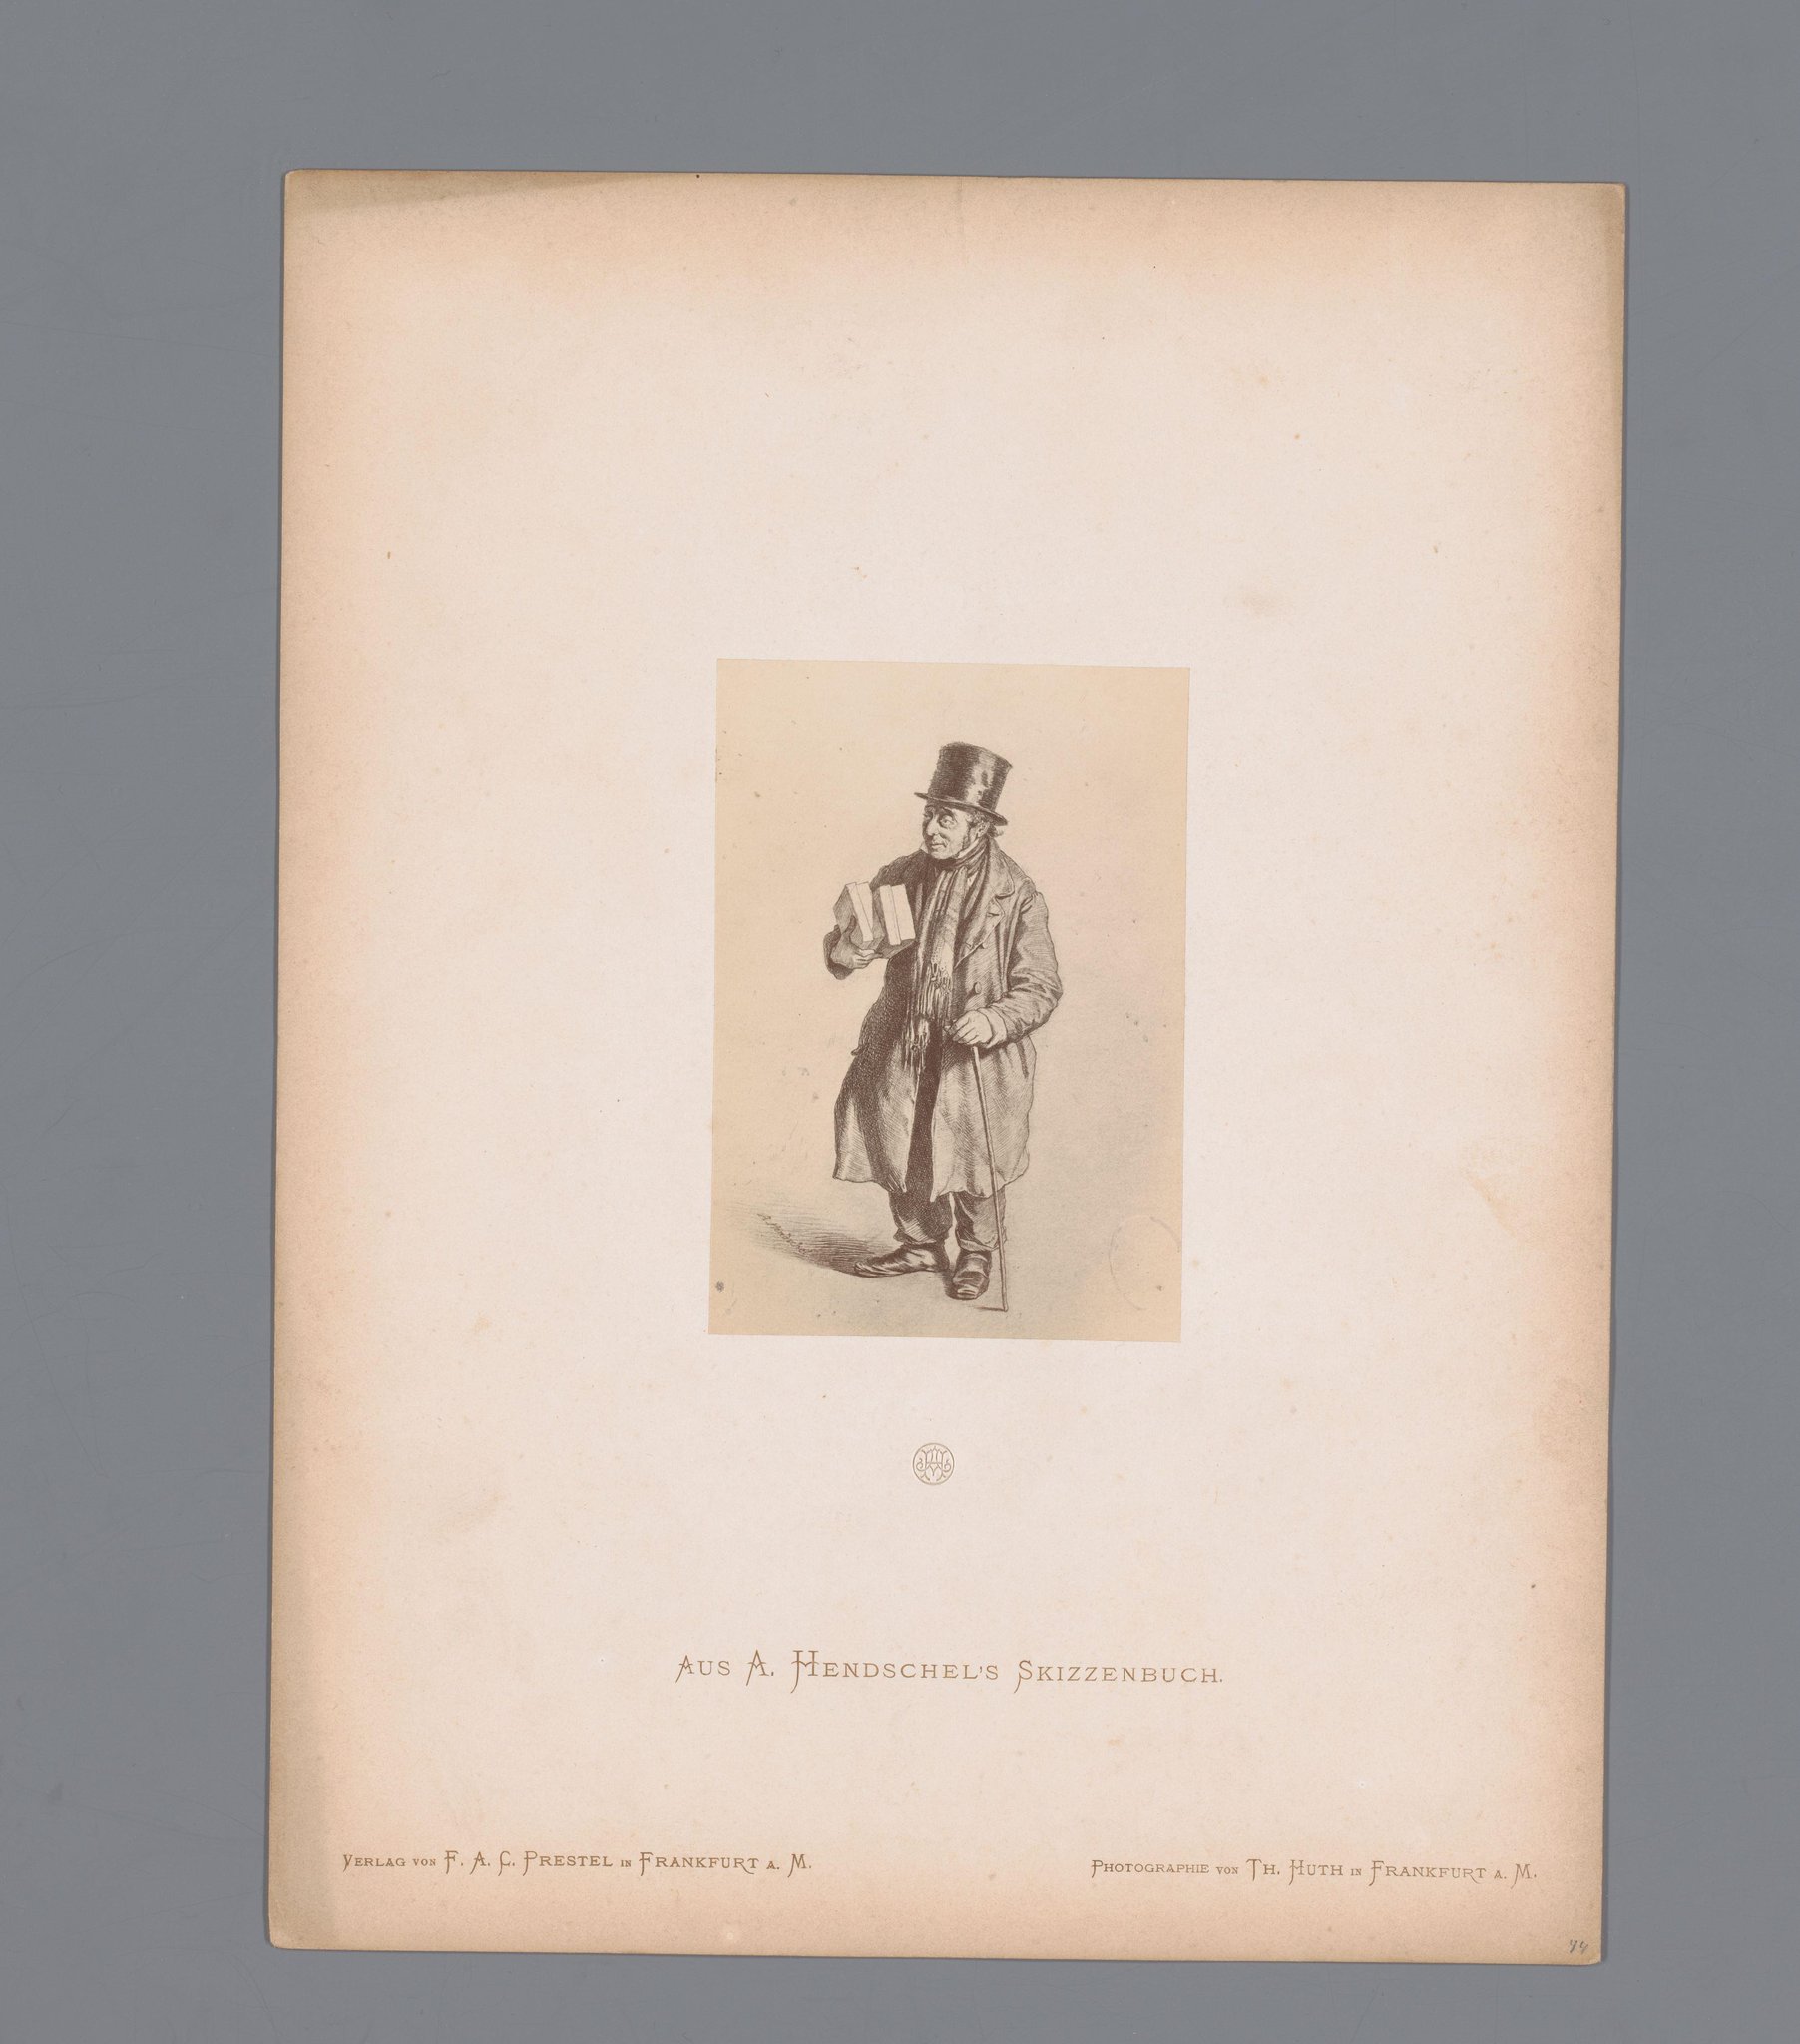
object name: photograph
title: Aus A. Hendschel's Skizzenbuch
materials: photographic support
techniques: albumen print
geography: frankfurt am main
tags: soap, merchant, salesman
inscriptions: monogram: ‘AH’, number: ‘44’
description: Deze foto maakt deel uit van een omslag met 50 foto's op 48 bladen, een lijst van afbeeldingen en een titelblad.